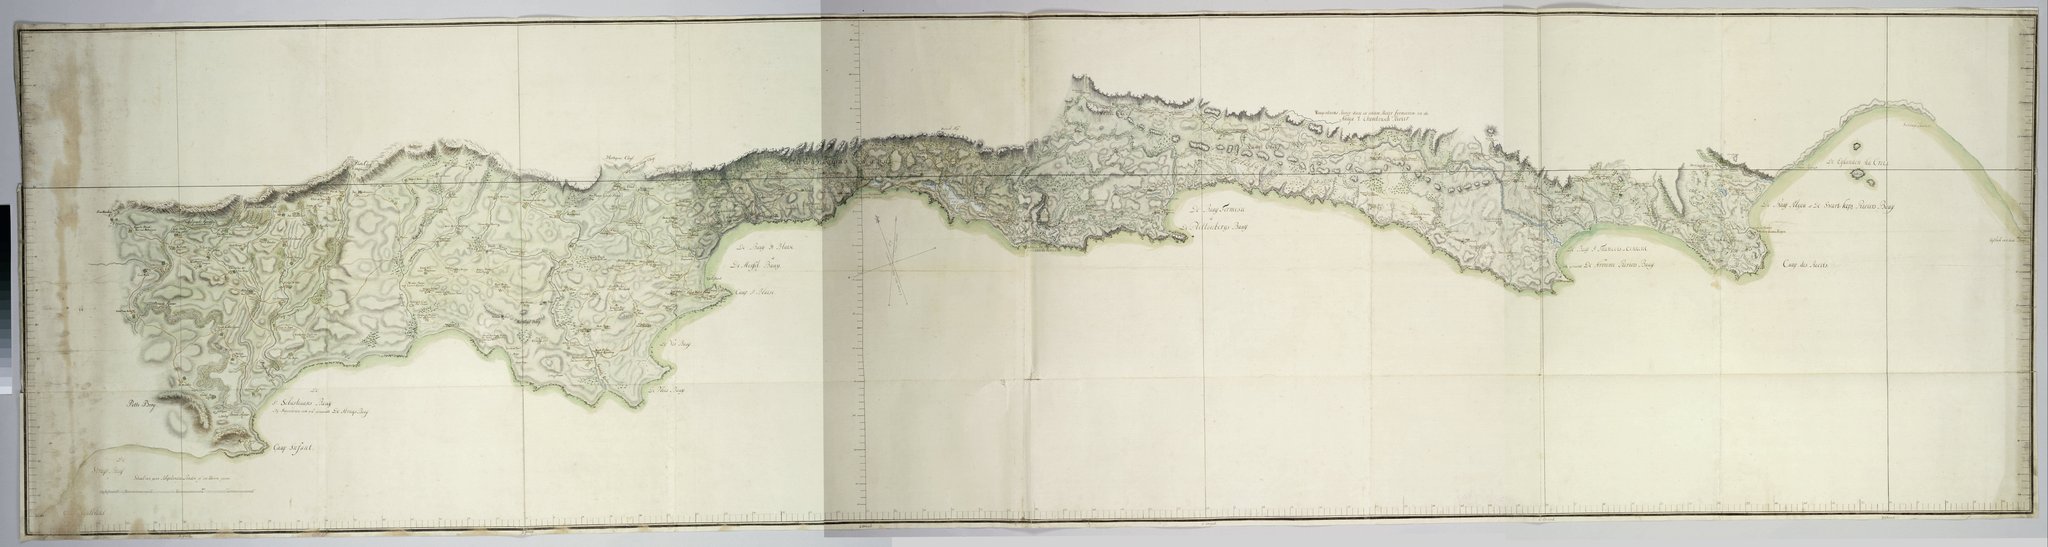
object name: map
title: Map of the south coast of South Africa between Cape Agulhas and the Sundays River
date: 1789-1790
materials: ink, paper, pencil, watercolor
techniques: brush, pen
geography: cape province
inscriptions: annotation